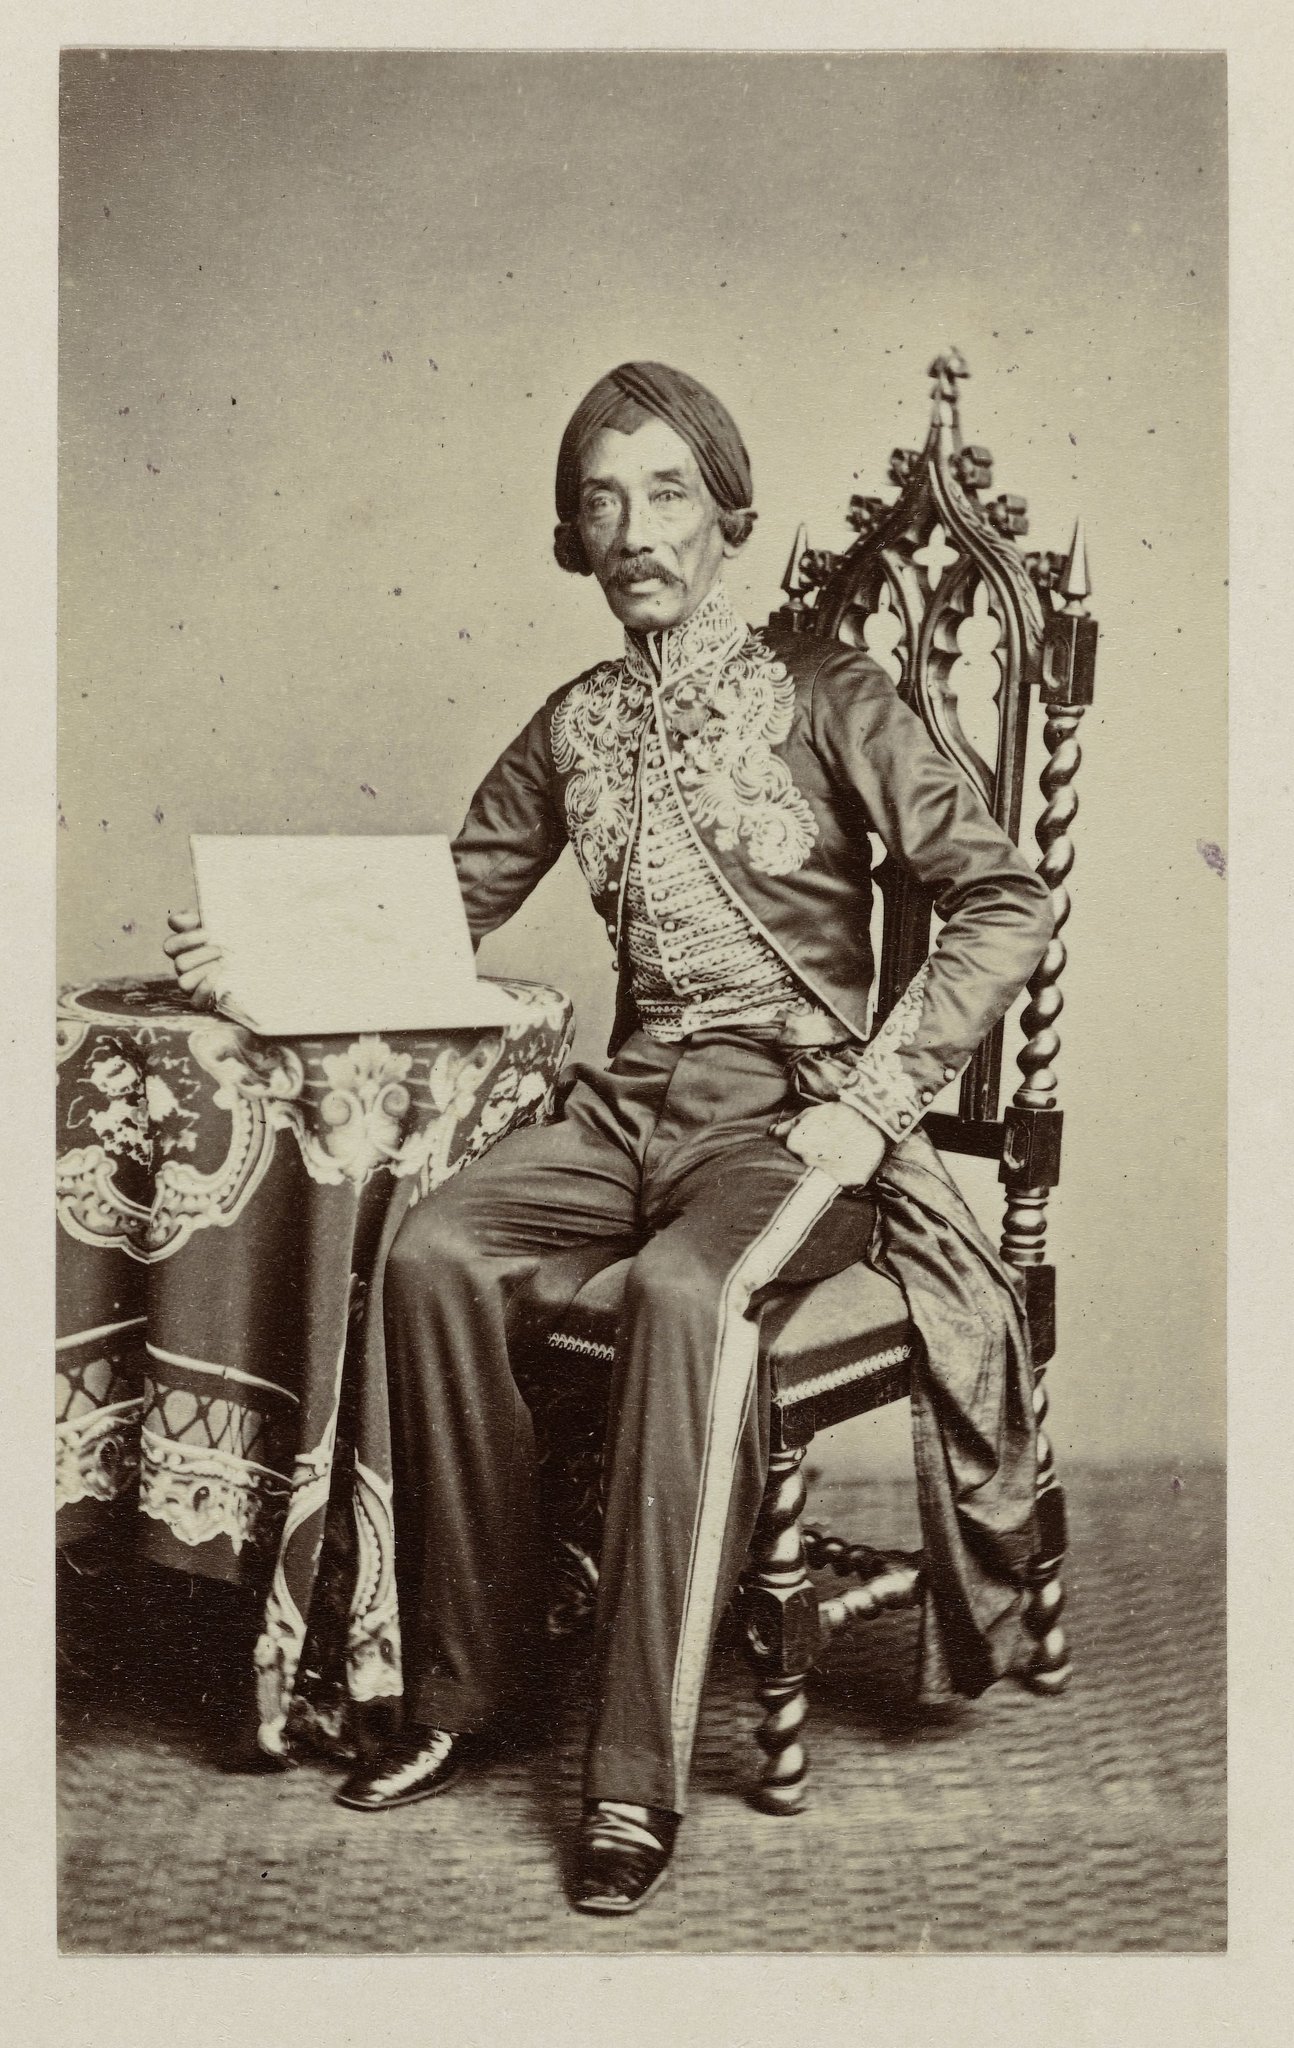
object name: photograph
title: De schilder Raden Saleh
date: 1860-1872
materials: photographic support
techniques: albumen print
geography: batavia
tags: painter, draughtsman, raden sarief bastaman saleh, historical persons, portrait, self-portrait of painter, portrait, self-portrait of artist, java, batavia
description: Studioportret van de Javaanse schilder Raden Sarief Bastaman Saleh, zittend in een stoel aan een tafel waarop een boek ligt. Ingeplakte foto in het fotoalbum getiteld: Gezichten van Java.